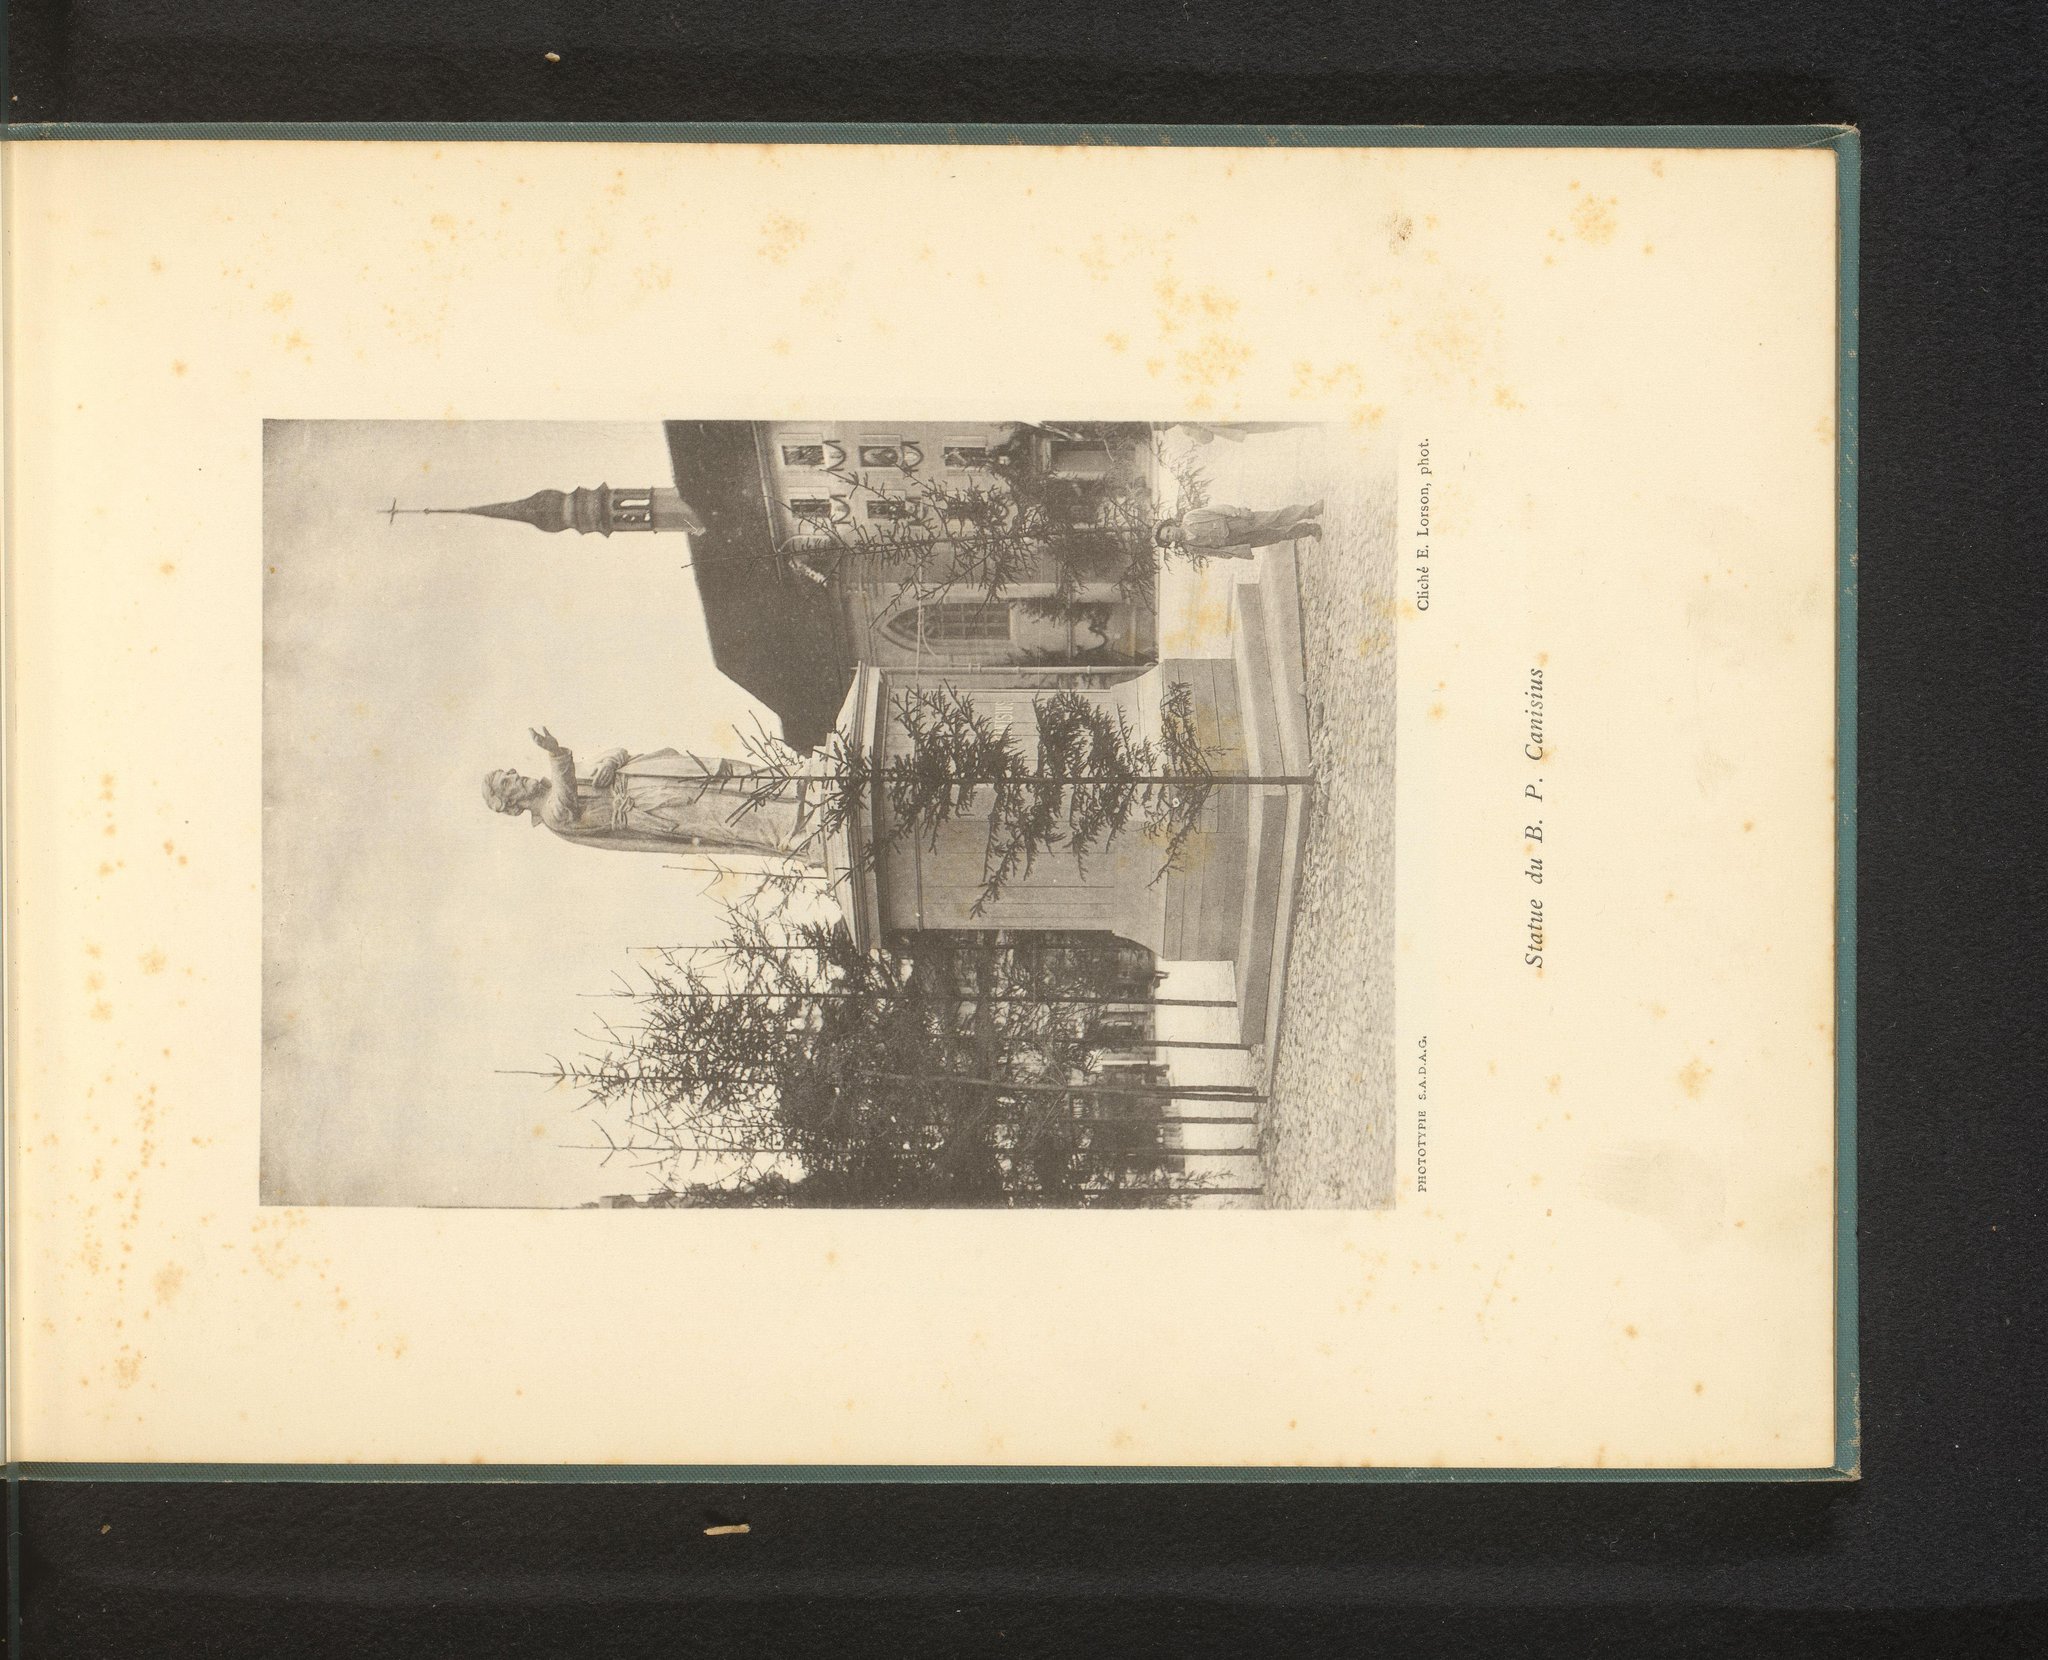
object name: photomechanical print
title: Standbeeld van Petrus Canisius in Fribourg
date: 1897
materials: paper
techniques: photograph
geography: fribourg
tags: nijmegen, square, place, circus, etc., monument, statue